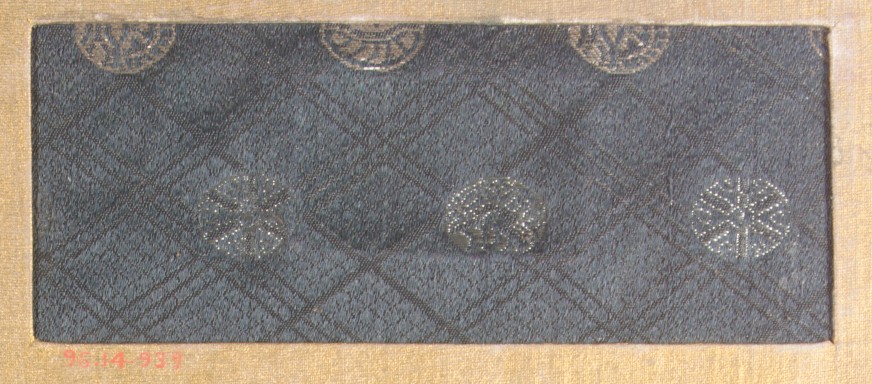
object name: piece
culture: japanese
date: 1701-1900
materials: silk